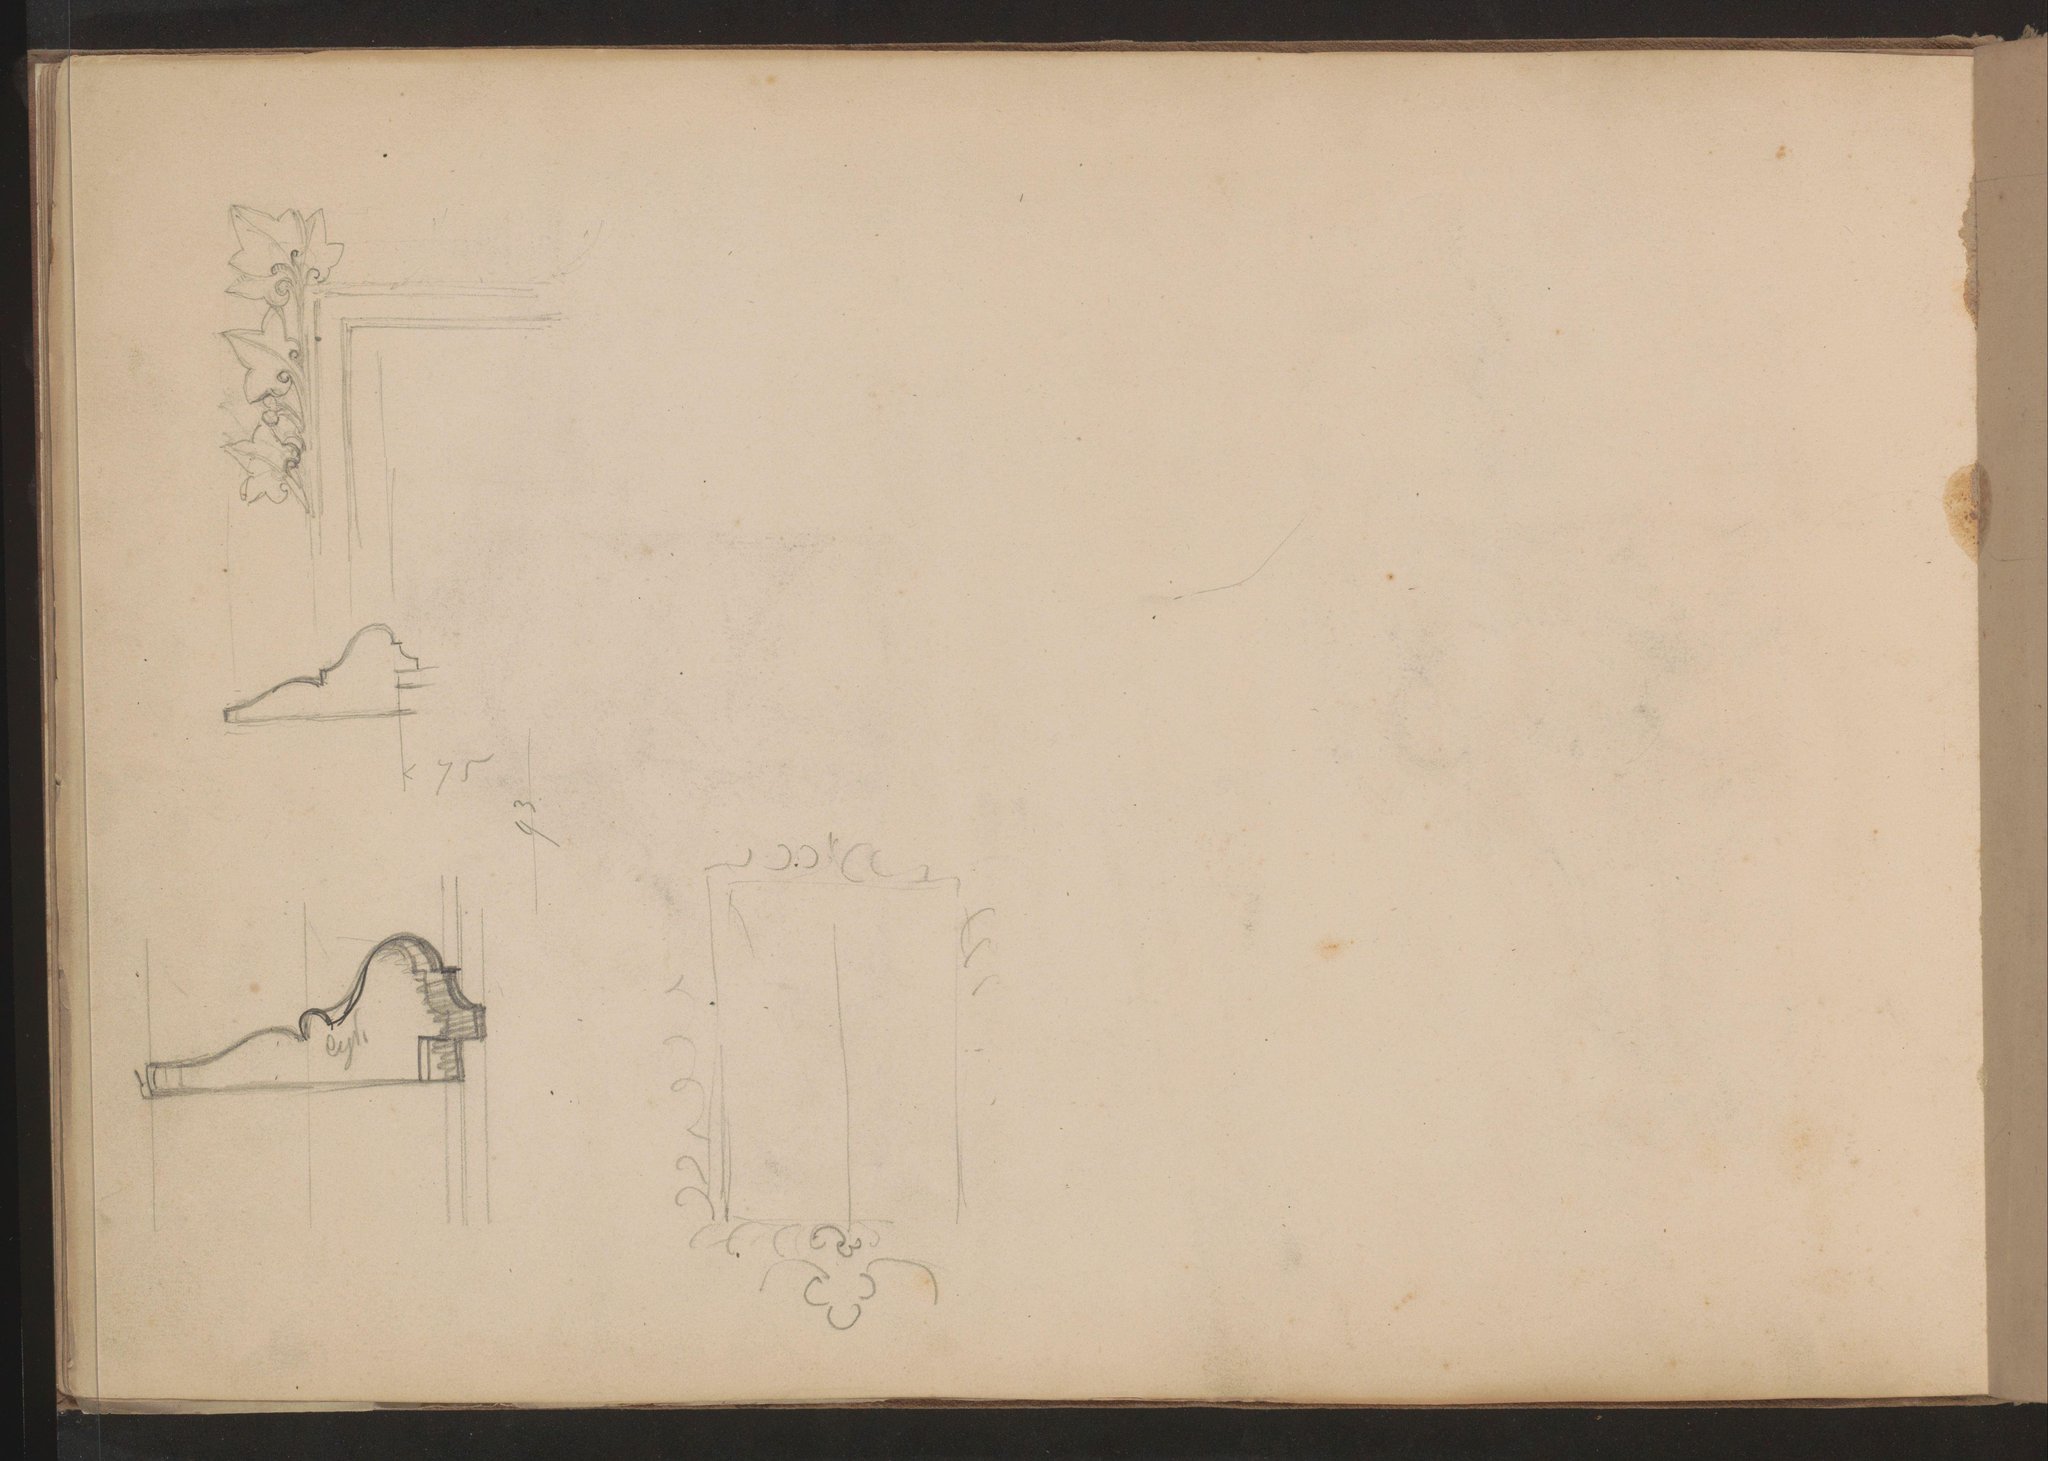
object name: sketchbook leaf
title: Architectonische details en een lijst versierd met een bladmotief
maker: pierre joseph hubert cuypers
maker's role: draughtsman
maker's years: 1827-1921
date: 1837-1921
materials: paper, pencil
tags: architectural detail, foliage, tendrils, branches ~ ornament, frame of painting, etc.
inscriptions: annotation: ‘[...]’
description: Blad 22 verso uit een schetsboek met 23 bladen.